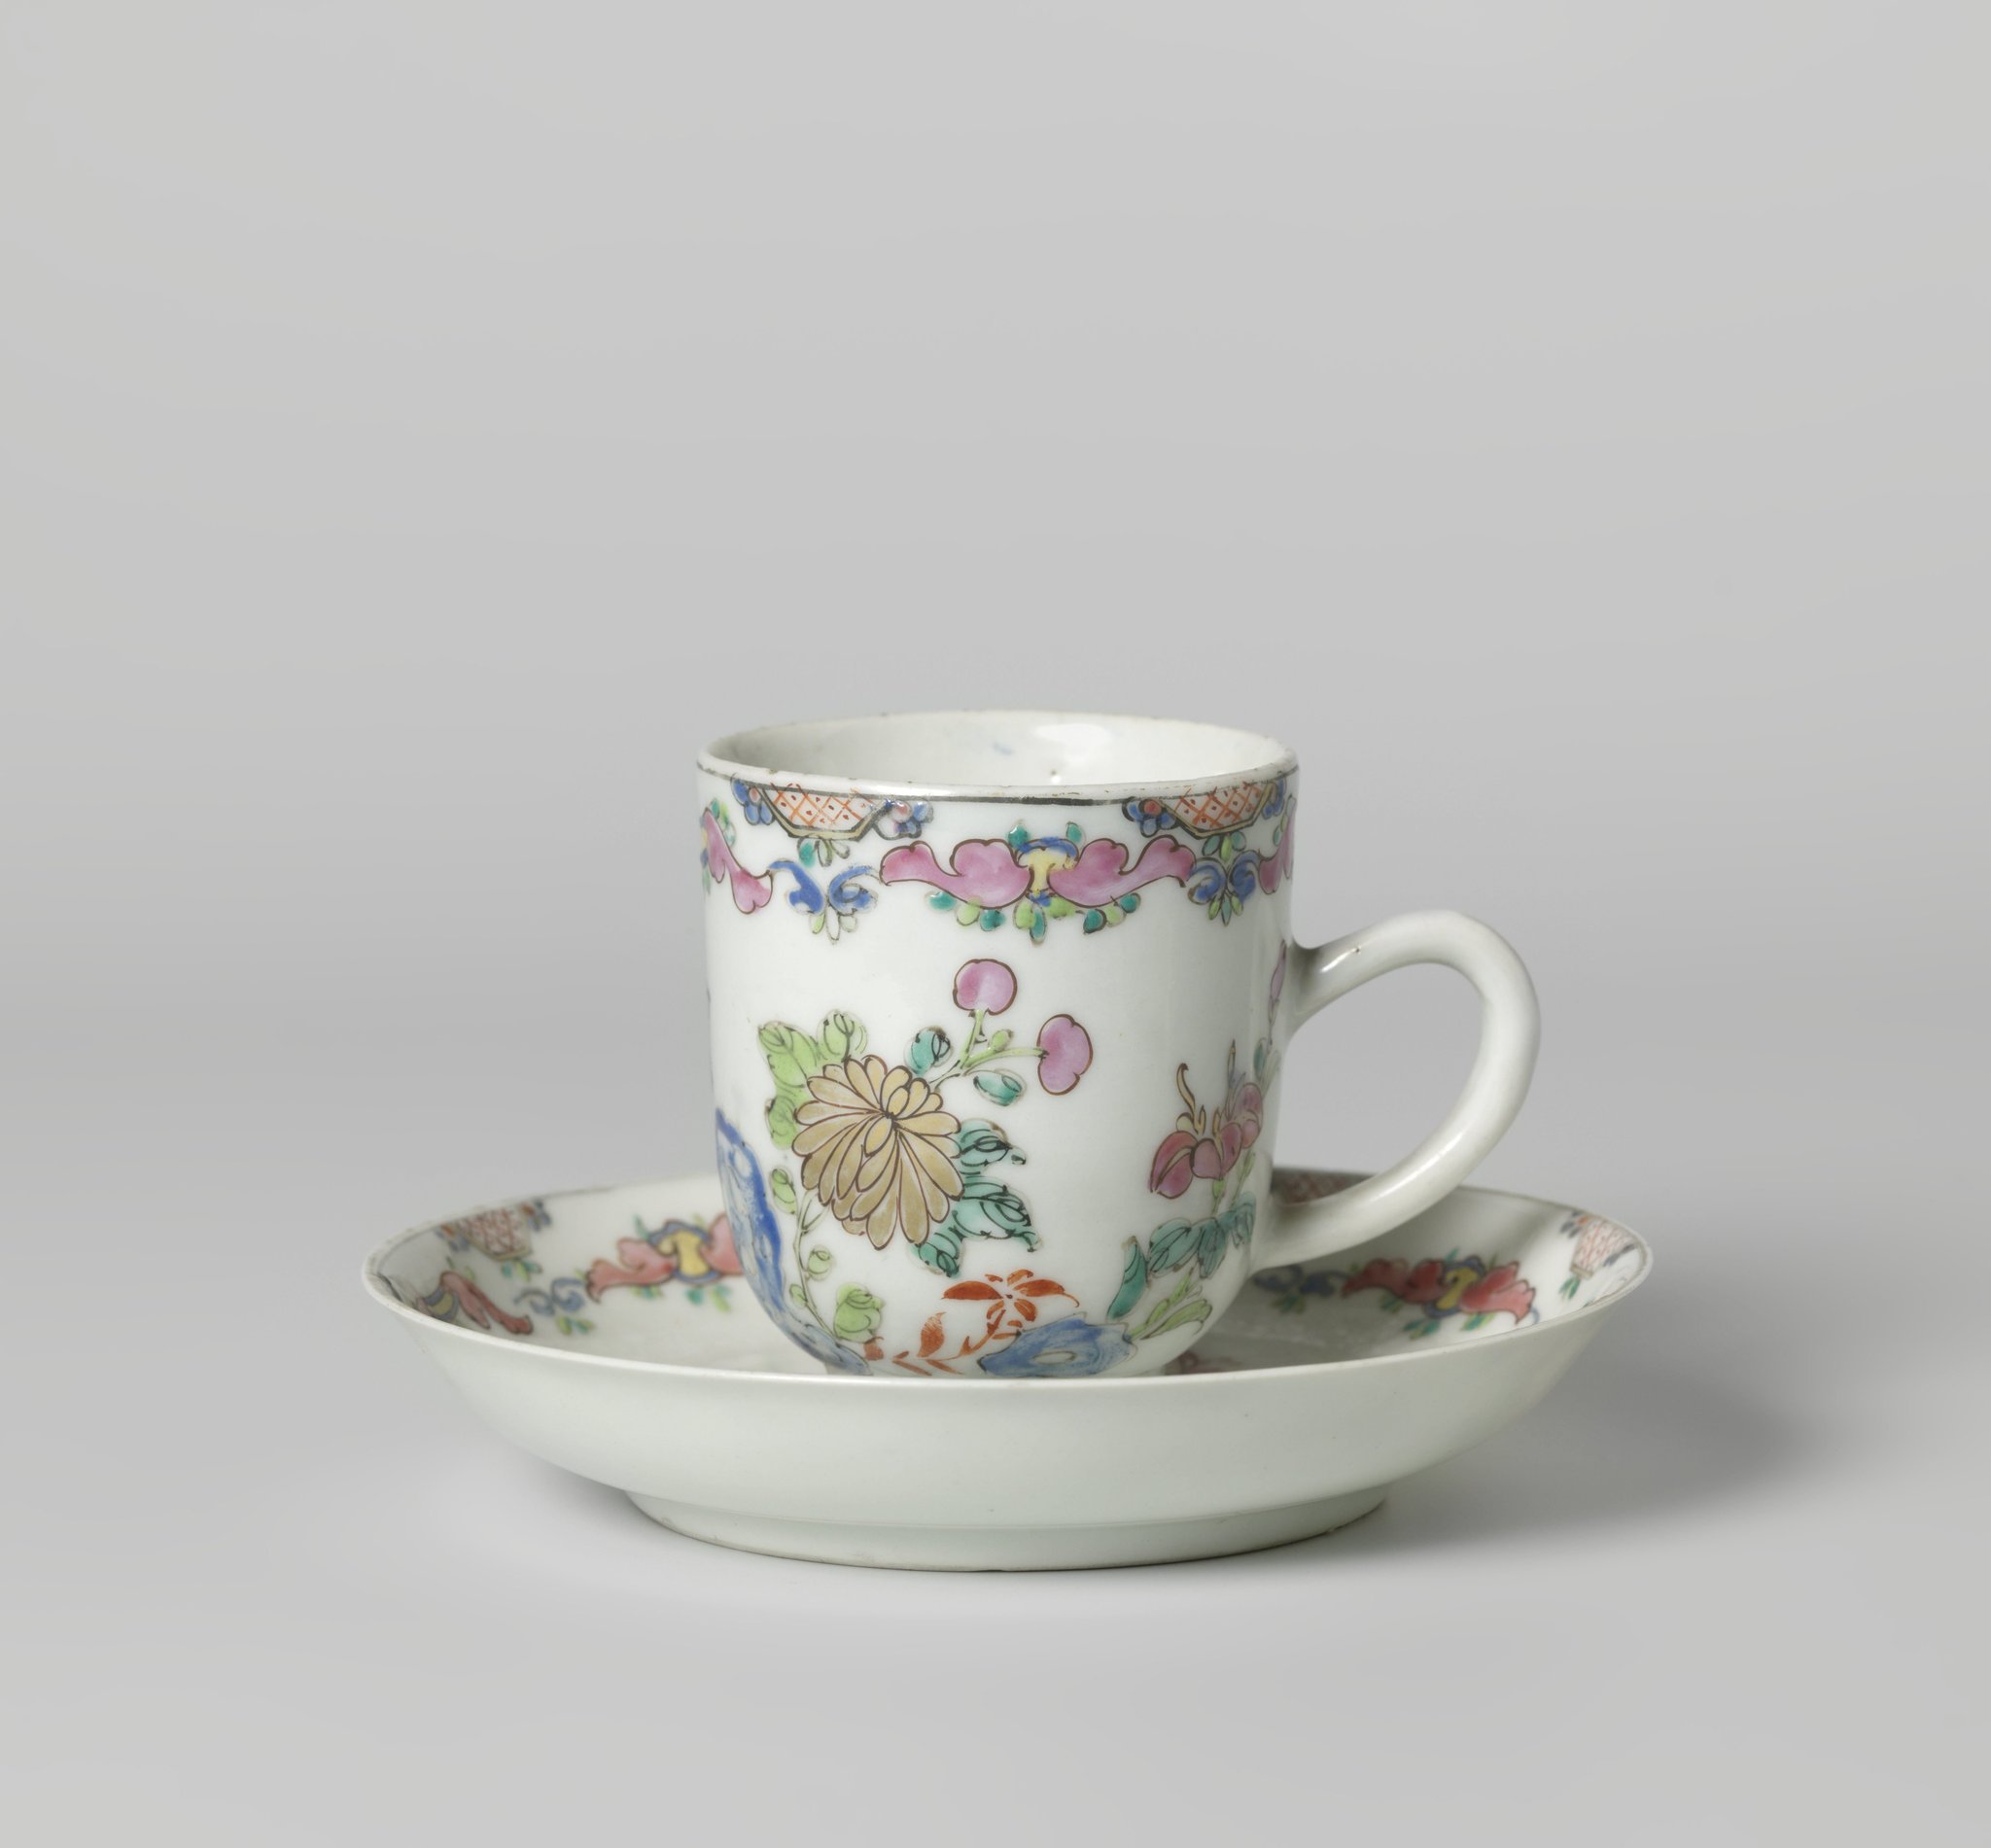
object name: chocolate cup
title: Chocolate cup and saucer with flowering plants near a rock and scrolls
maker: Anonymous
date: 1725-1749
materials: glaze, gold, paint, porcelain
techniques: firing, gilding, turning, vitrification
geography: china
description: Kop en schotel, versierd in kleuren met bloemen.